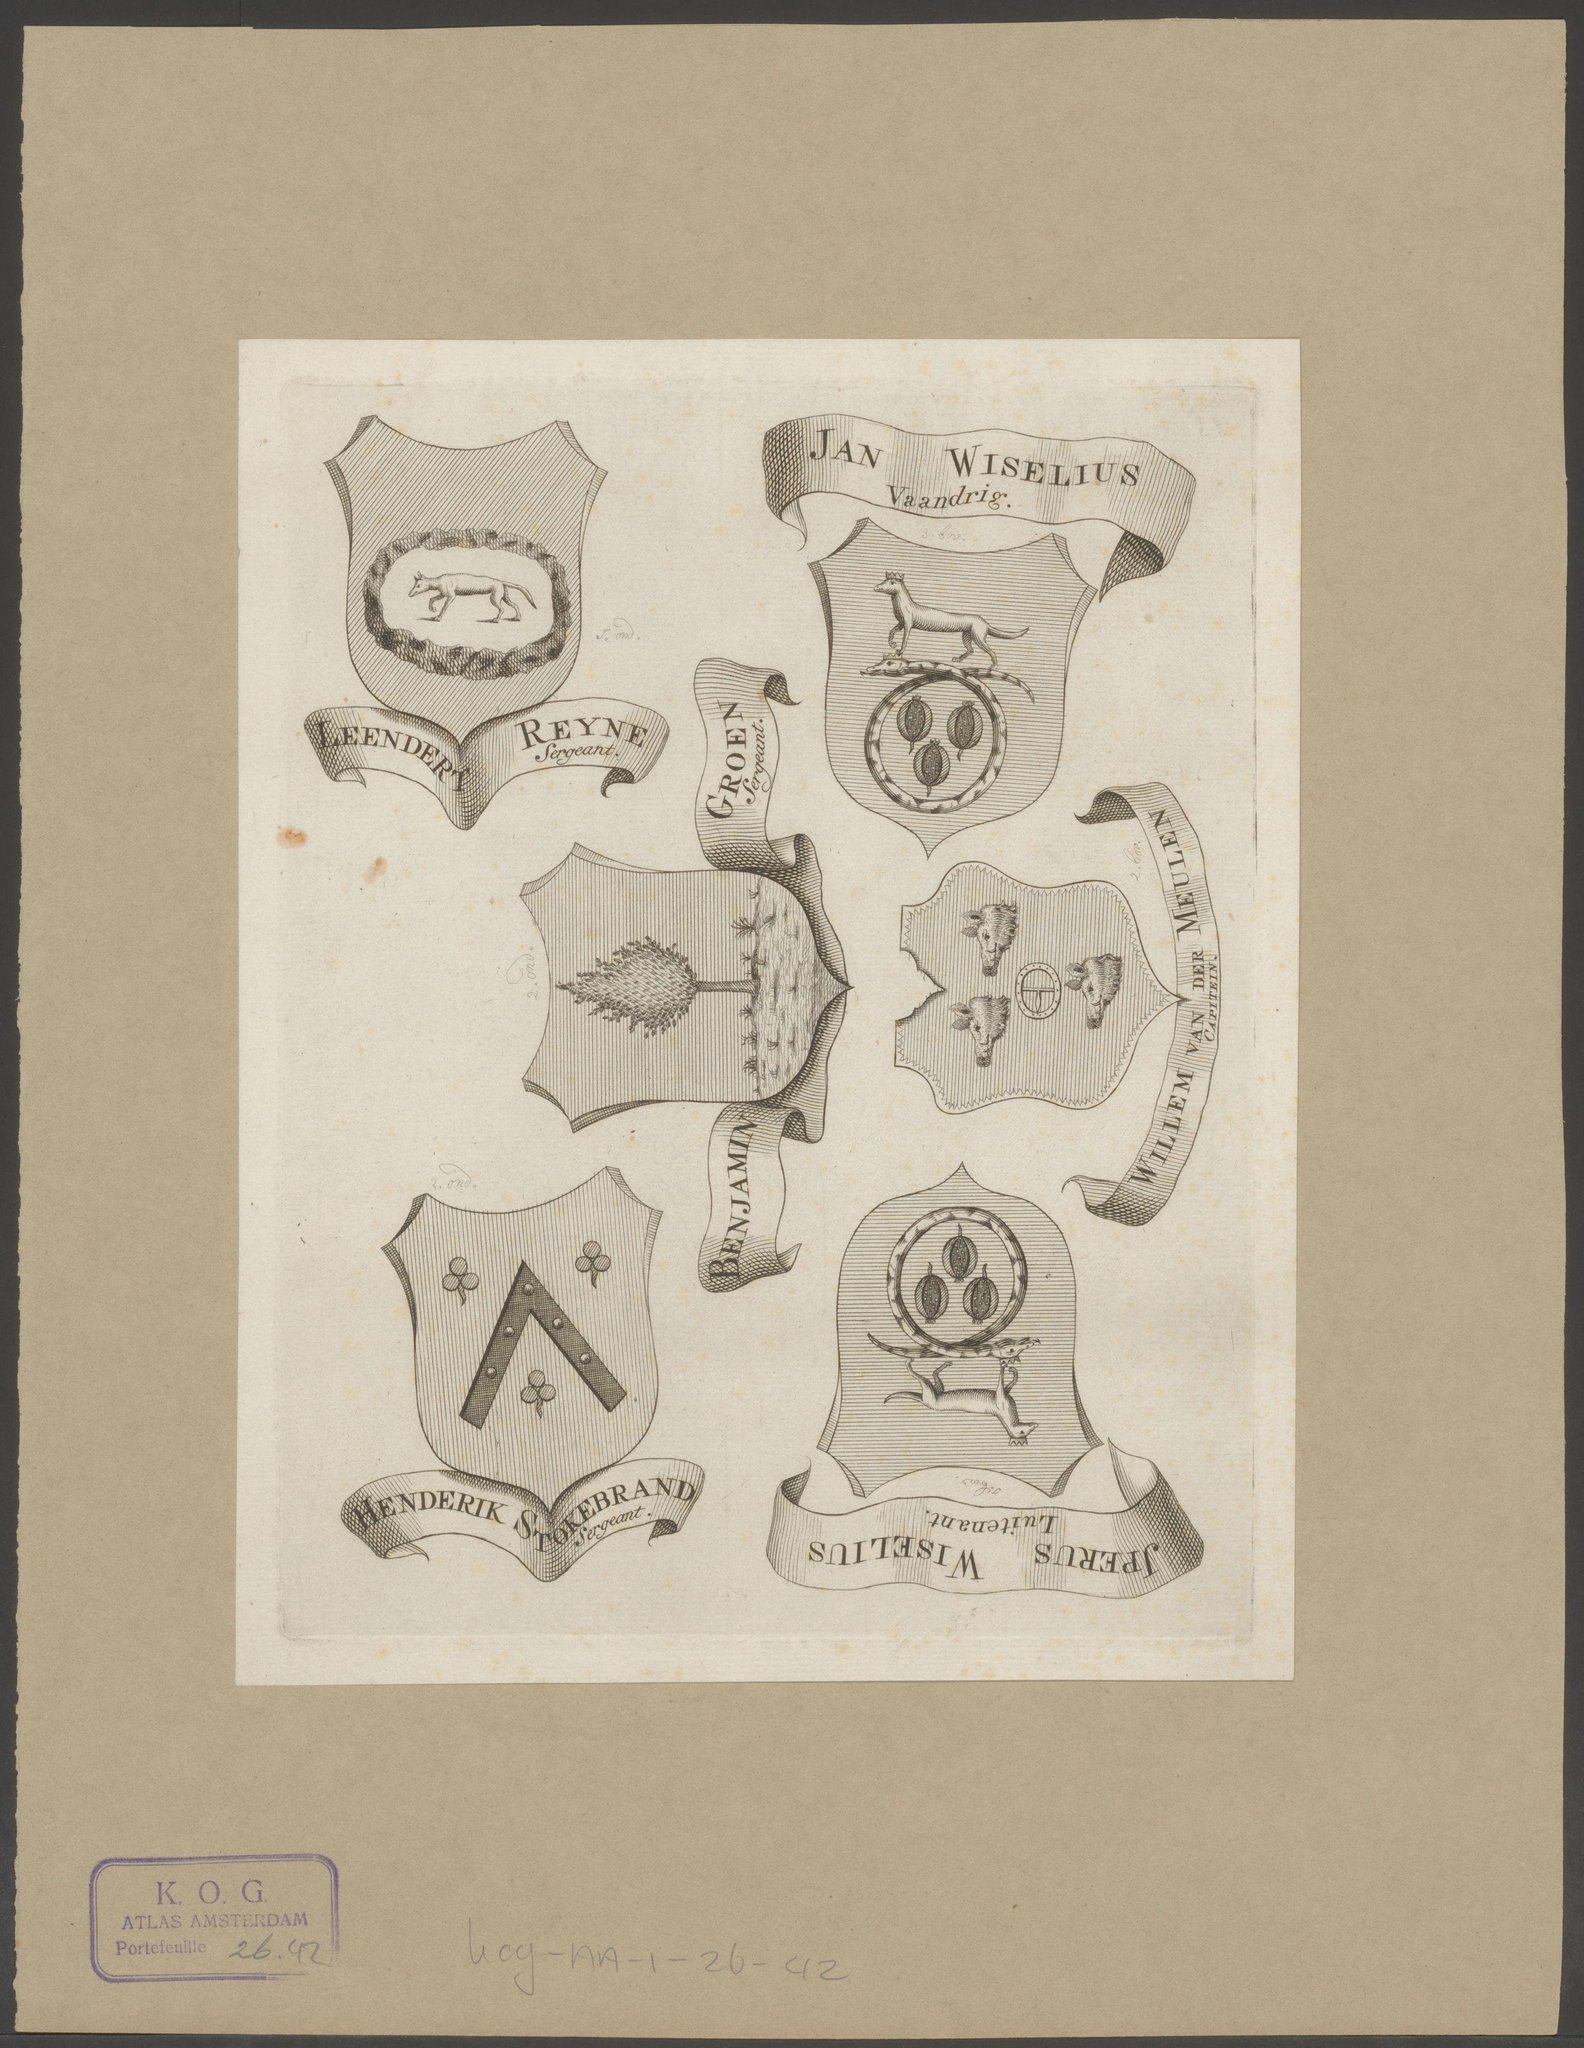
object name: print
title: Zes wapens en banderollen met namen en titels van officieren van burgerwijk LII te Amsterdam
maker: Anonymous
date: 1765-1772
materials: paper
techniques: engraving, etching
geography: northern netherlands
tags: armorial bearing, heraldry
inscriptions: collector's mark: Lugt 1641b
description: De wapens en banderollen dienden uitgesneden en op een plattegrond van burgerwijk LII geplakt te worden. Zie KOG-AA-1-26-33.